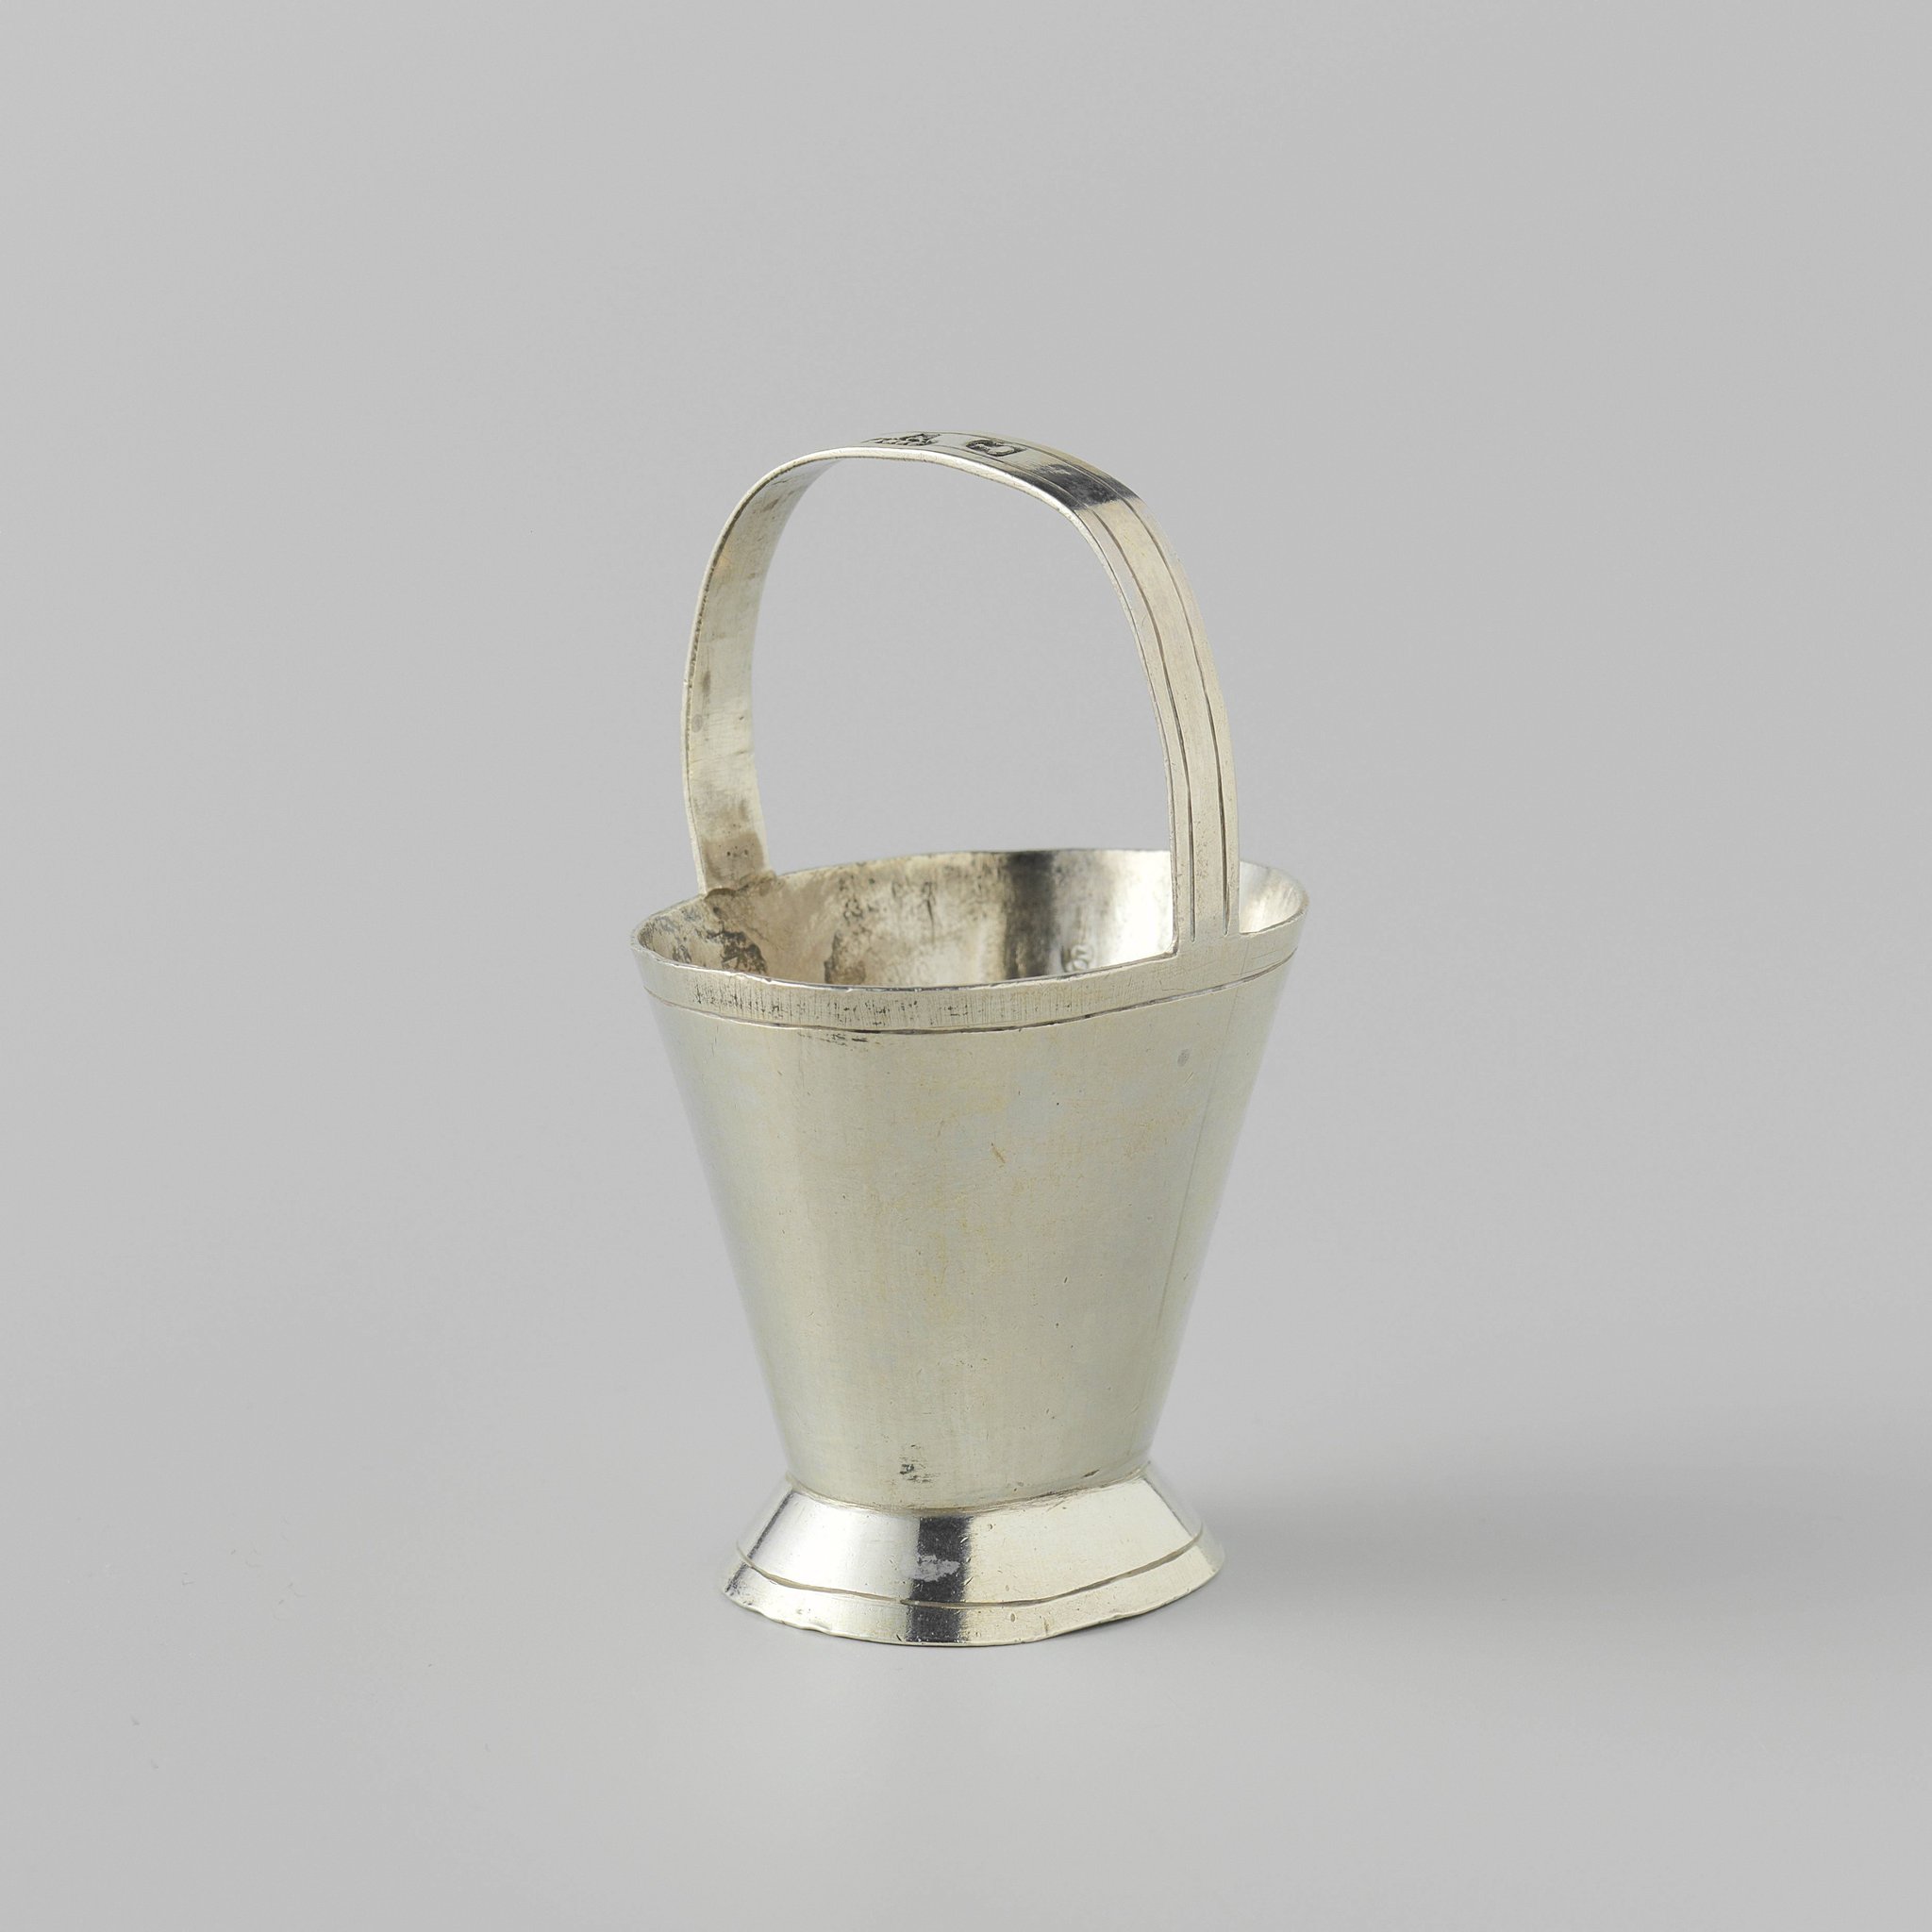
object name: miniature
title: Draagkorf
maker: johannes van somerwil (i)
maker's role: silversmith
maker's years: 1715-1764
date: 1757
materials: silver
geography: amsterdam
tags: container of metal: bucket, can, canister, drum, tin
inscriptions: date letter: ‘X (= 1757)’, town mark: ‘Amsterdam’, maker's mark: ‘boom in schild (Voet 443)’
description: Ovale, wijduitlopende marktemmer op een voet. De emmer heeft een vast hengsel en hij heeft gegraveerde lijnen langs de randen.